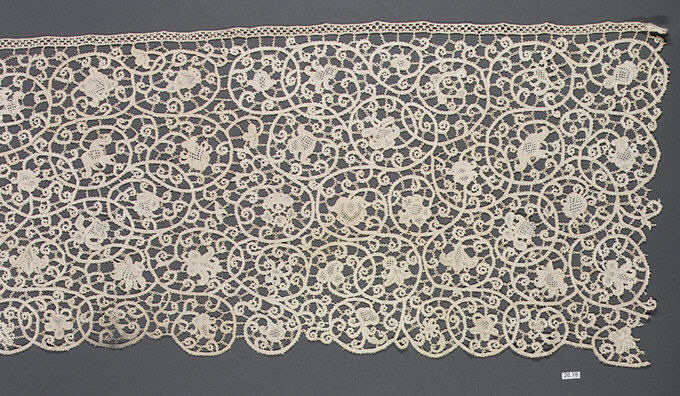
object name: flounce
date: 1601-1633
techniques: lace